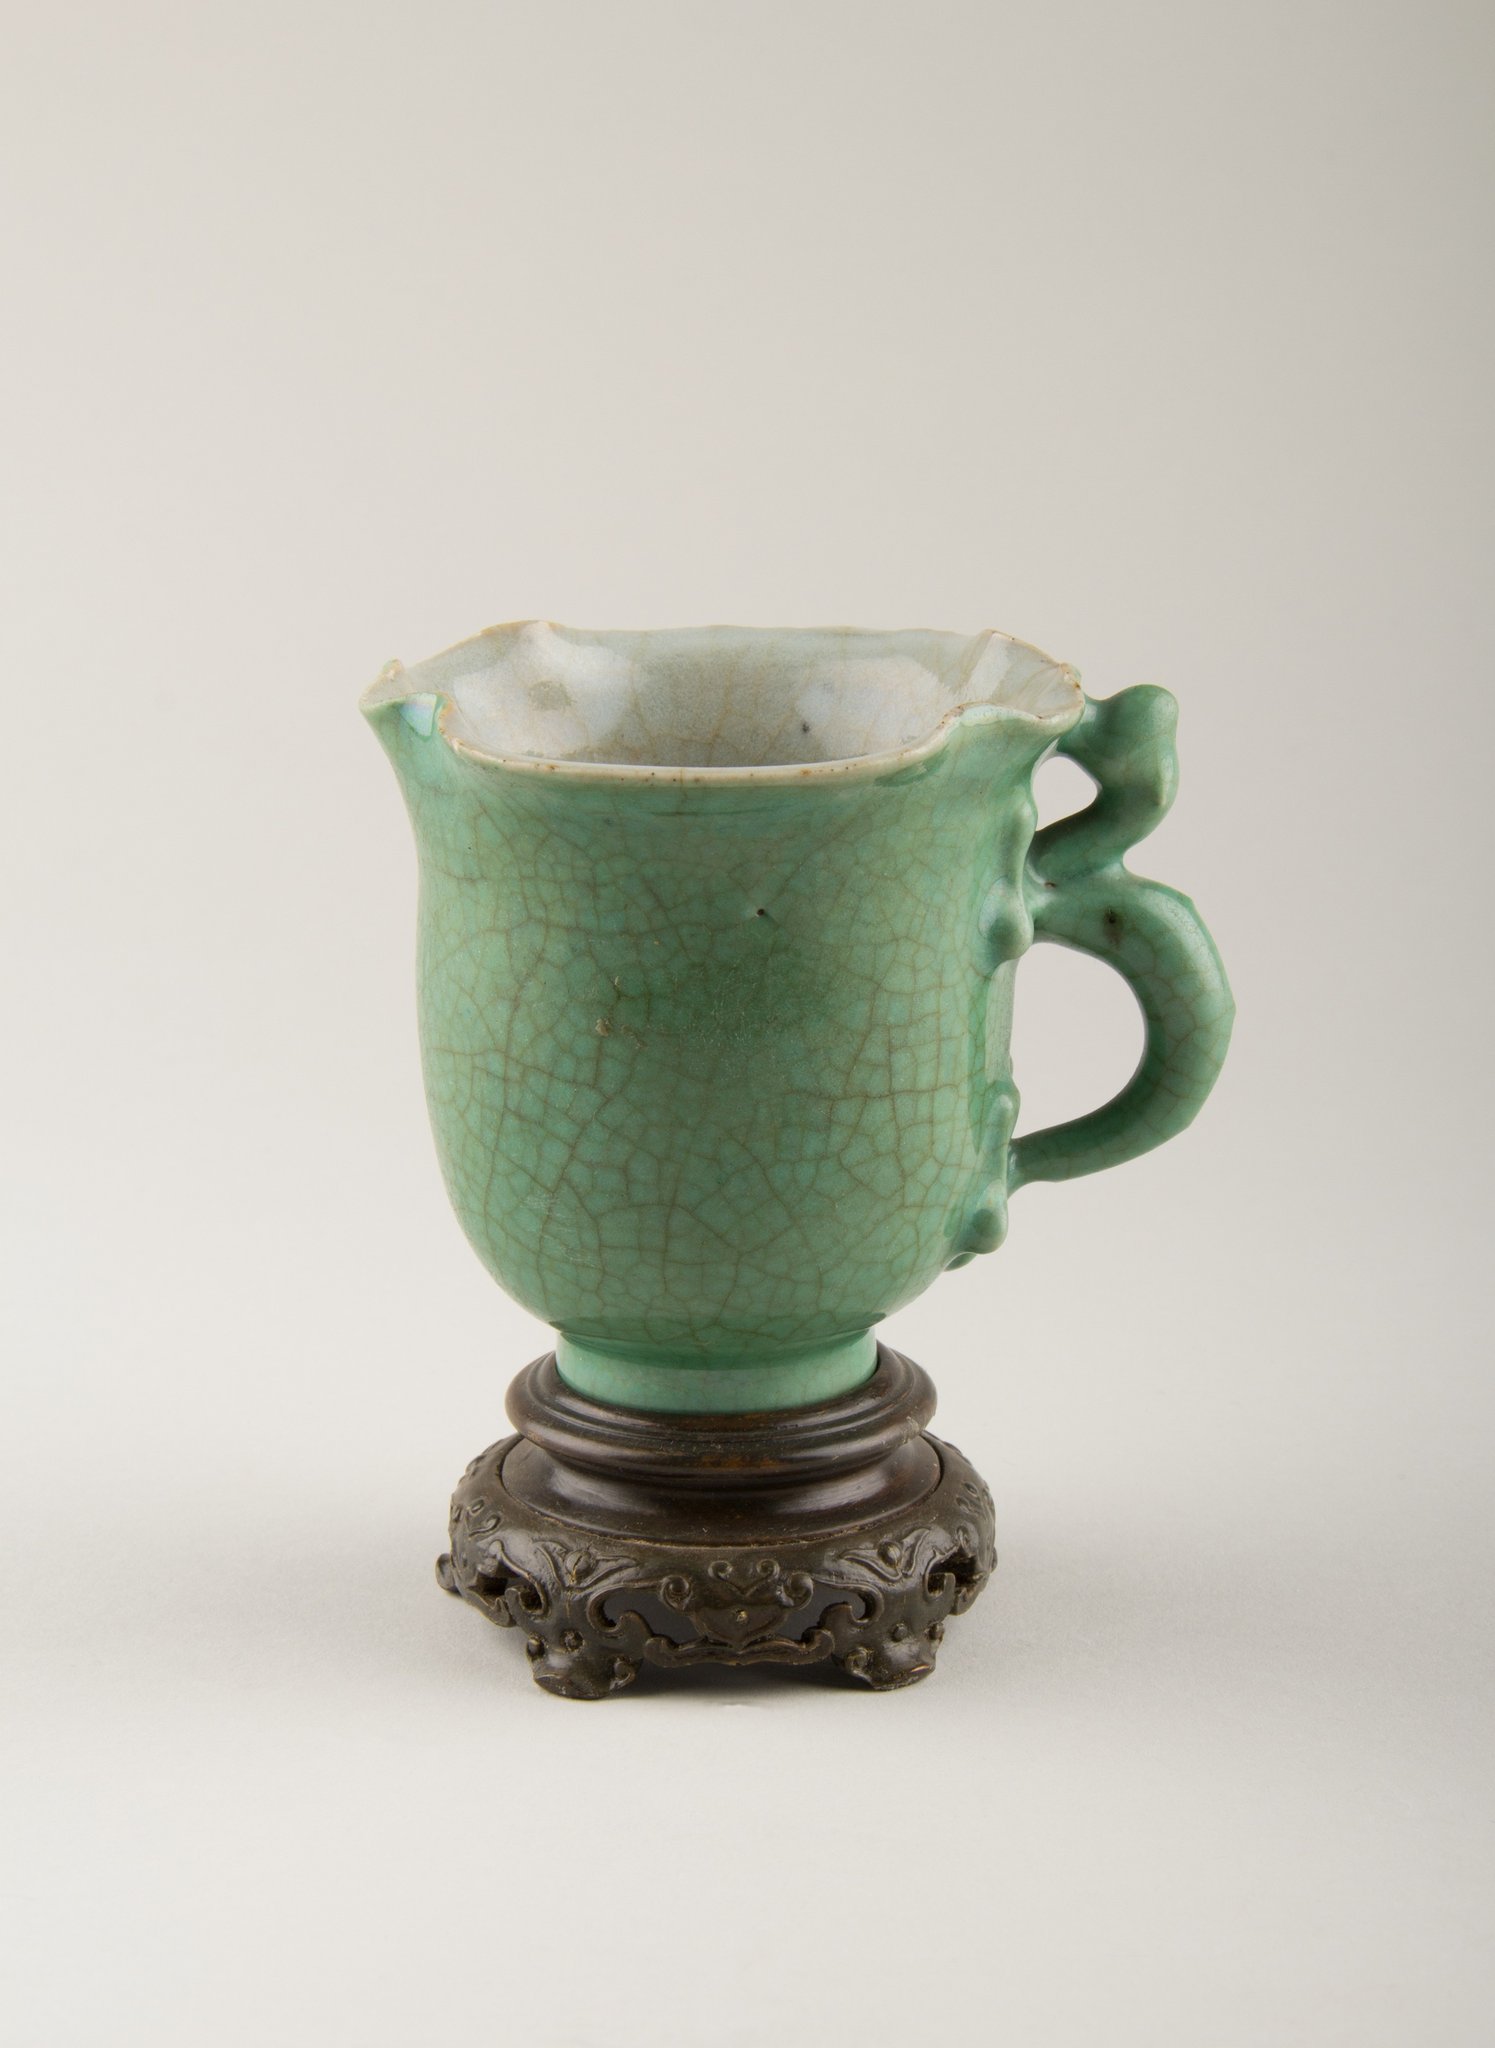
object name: cup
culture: chinese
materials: glaze, porcelain